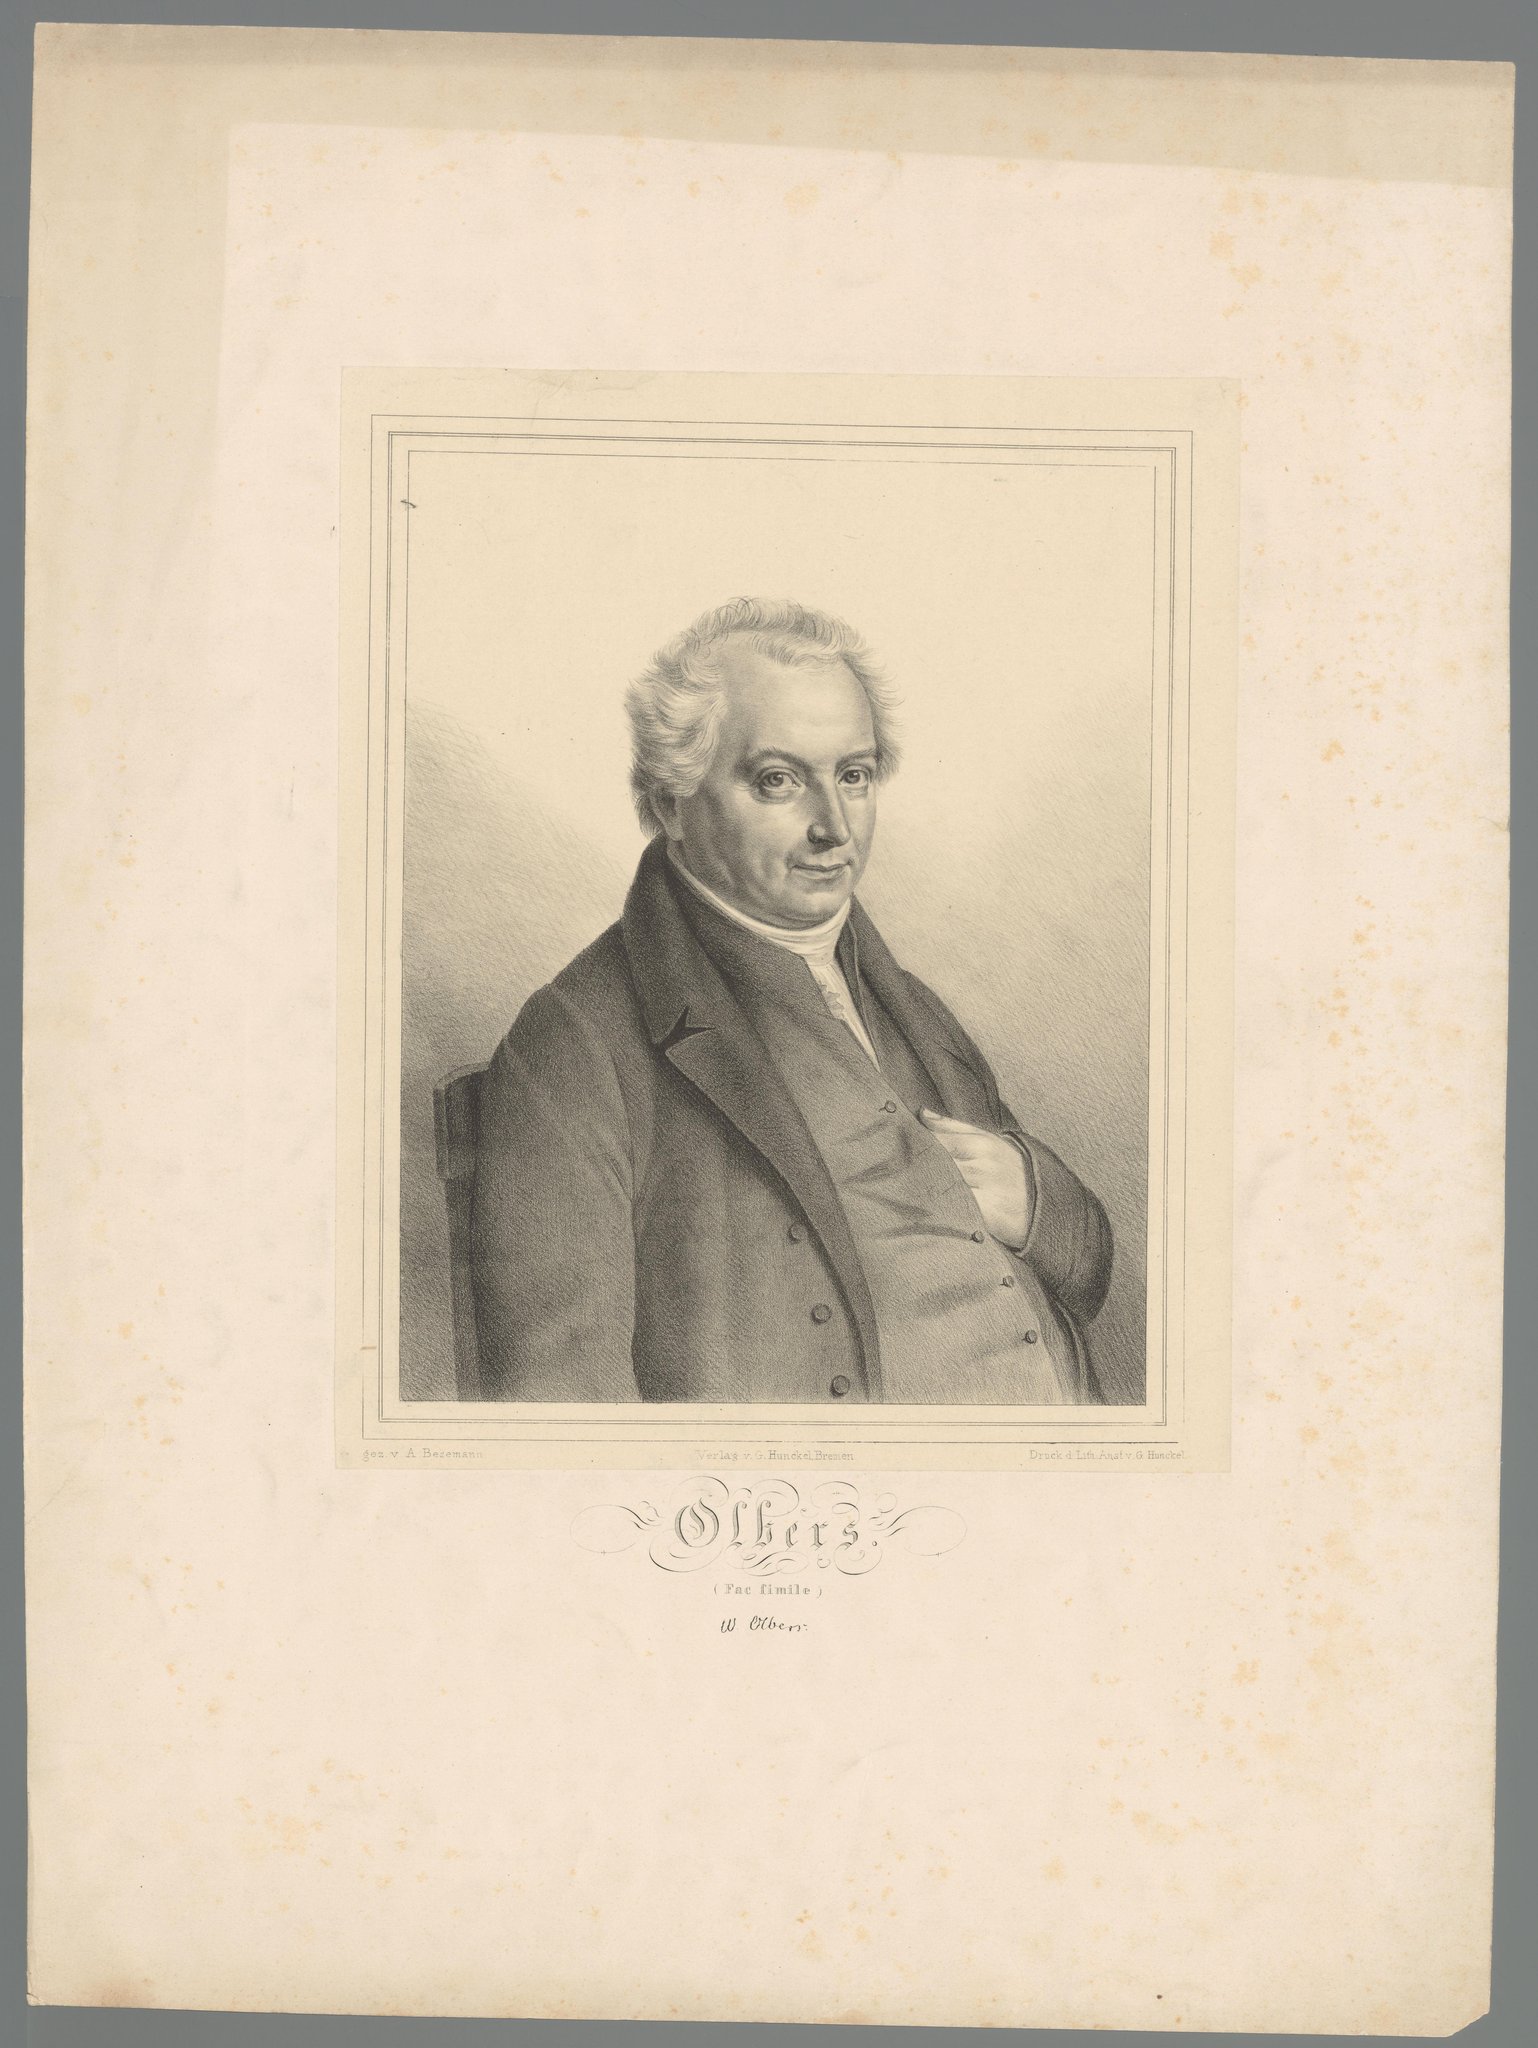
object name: print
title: Olbers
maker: georg justus hunckel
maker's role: printer, publisher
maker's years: 1808-1871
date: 1816-1841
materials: paper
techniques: lithograph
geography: bremen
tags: physicist, adult man, historical persons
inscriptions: collector's mark: Lugt 2228